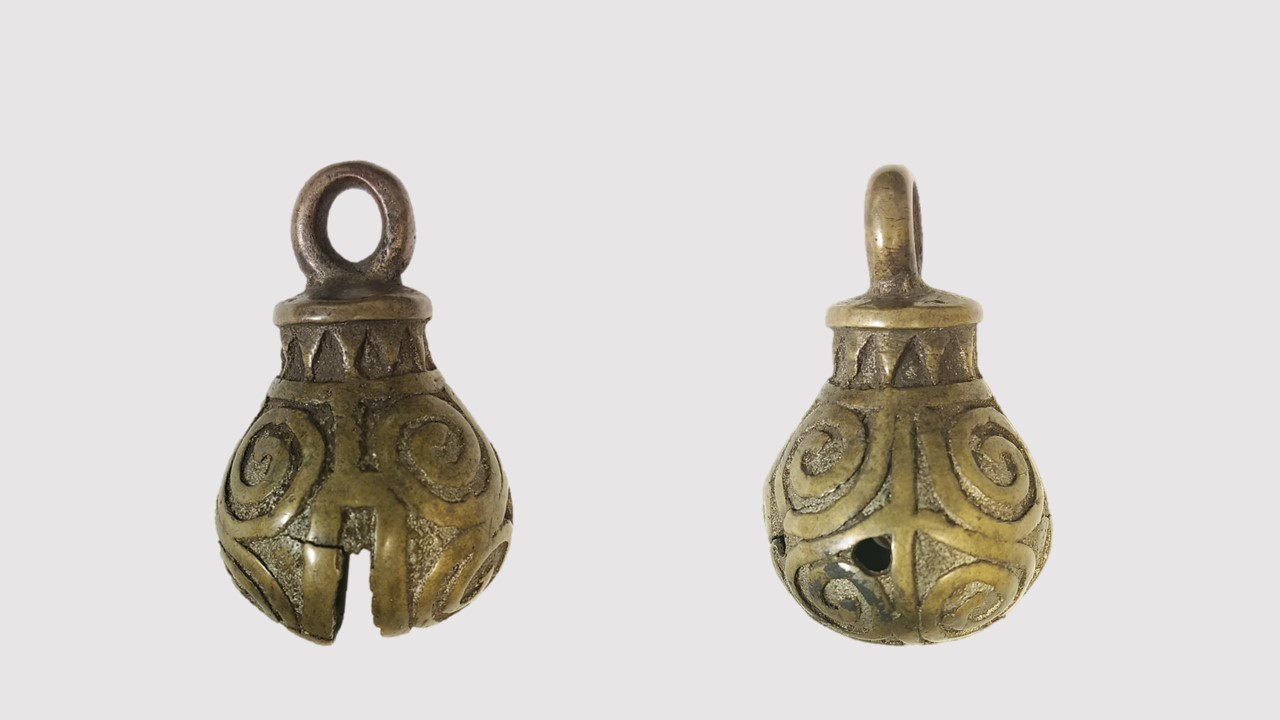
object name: garonong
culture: bornean or dyak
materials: brass, bronze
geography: borneo